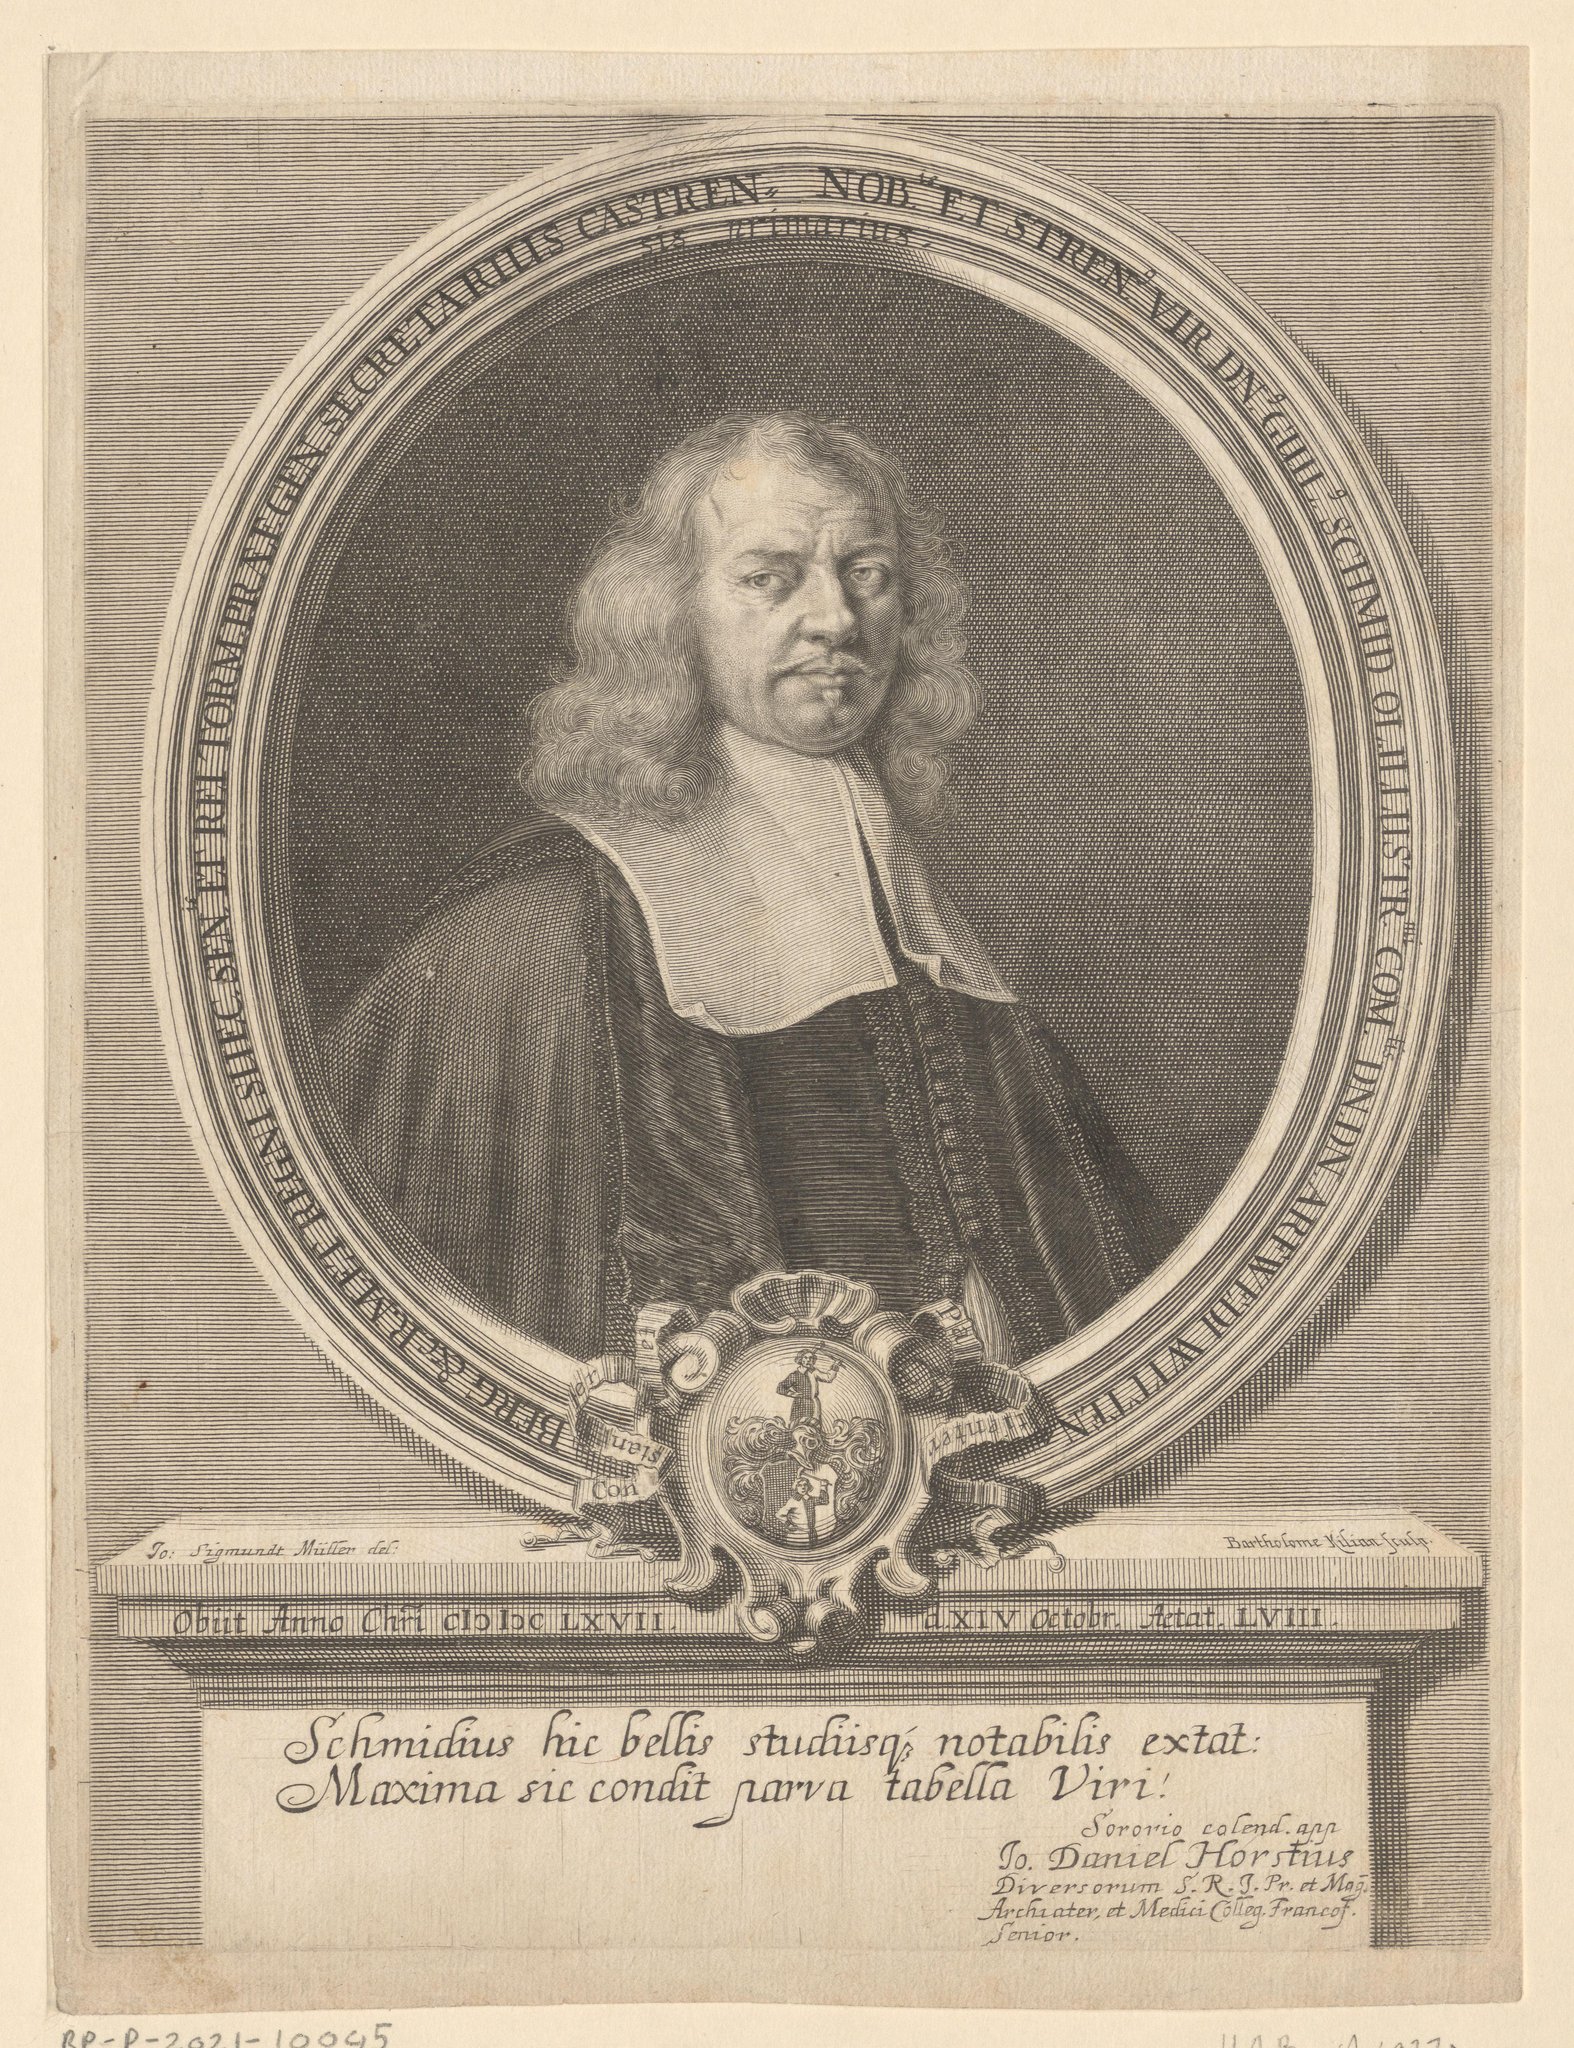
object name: print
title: Portret van Wilhelm Schmid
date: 1667-1696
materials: paper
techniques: engraving, etching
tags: historical persons, portrait of a writer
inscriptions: collector's mark: Lugt 2228